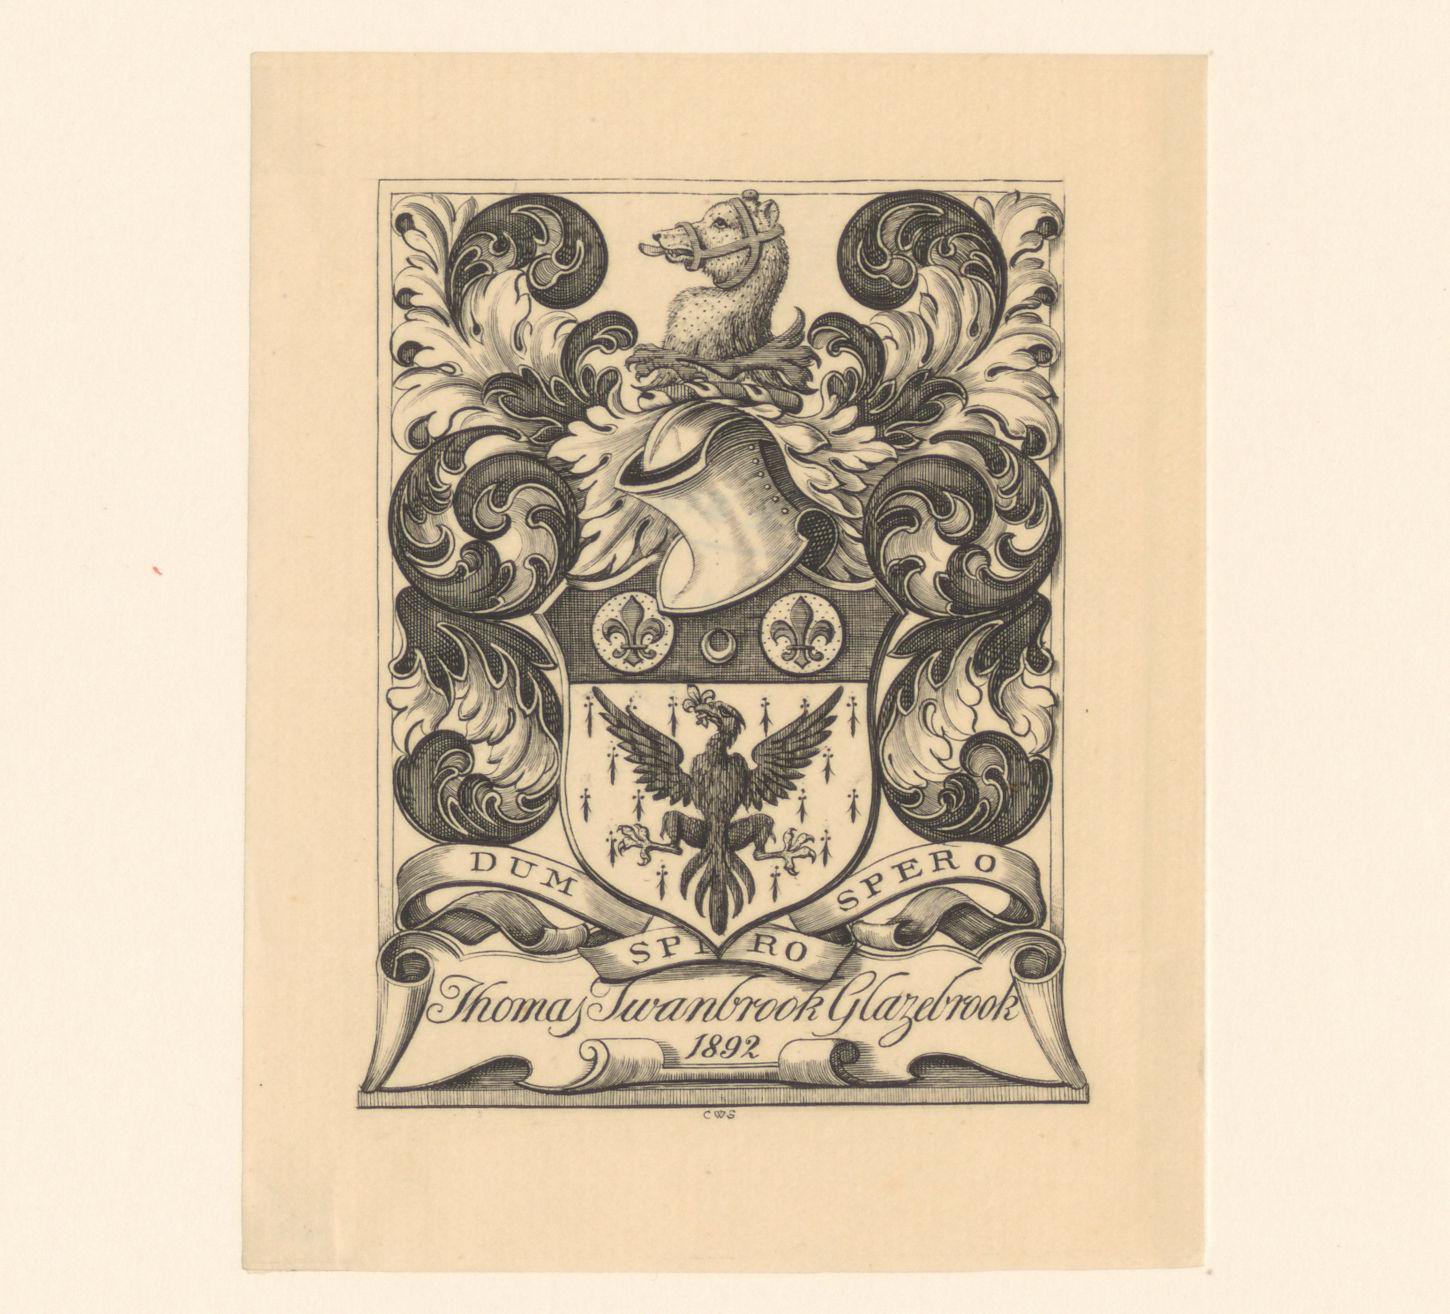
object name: bookplate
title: Ex libris van Thomas Swanbrook Glazebrook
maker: charles william sherborn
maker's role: print maker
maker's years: 1831-1912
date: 1892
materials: paper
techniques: engraving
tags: predatory birds: eagle, beasts of prey, predatory animals: bear, armorial bearing, heraldry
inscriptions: collector's mark: Lugt 2228